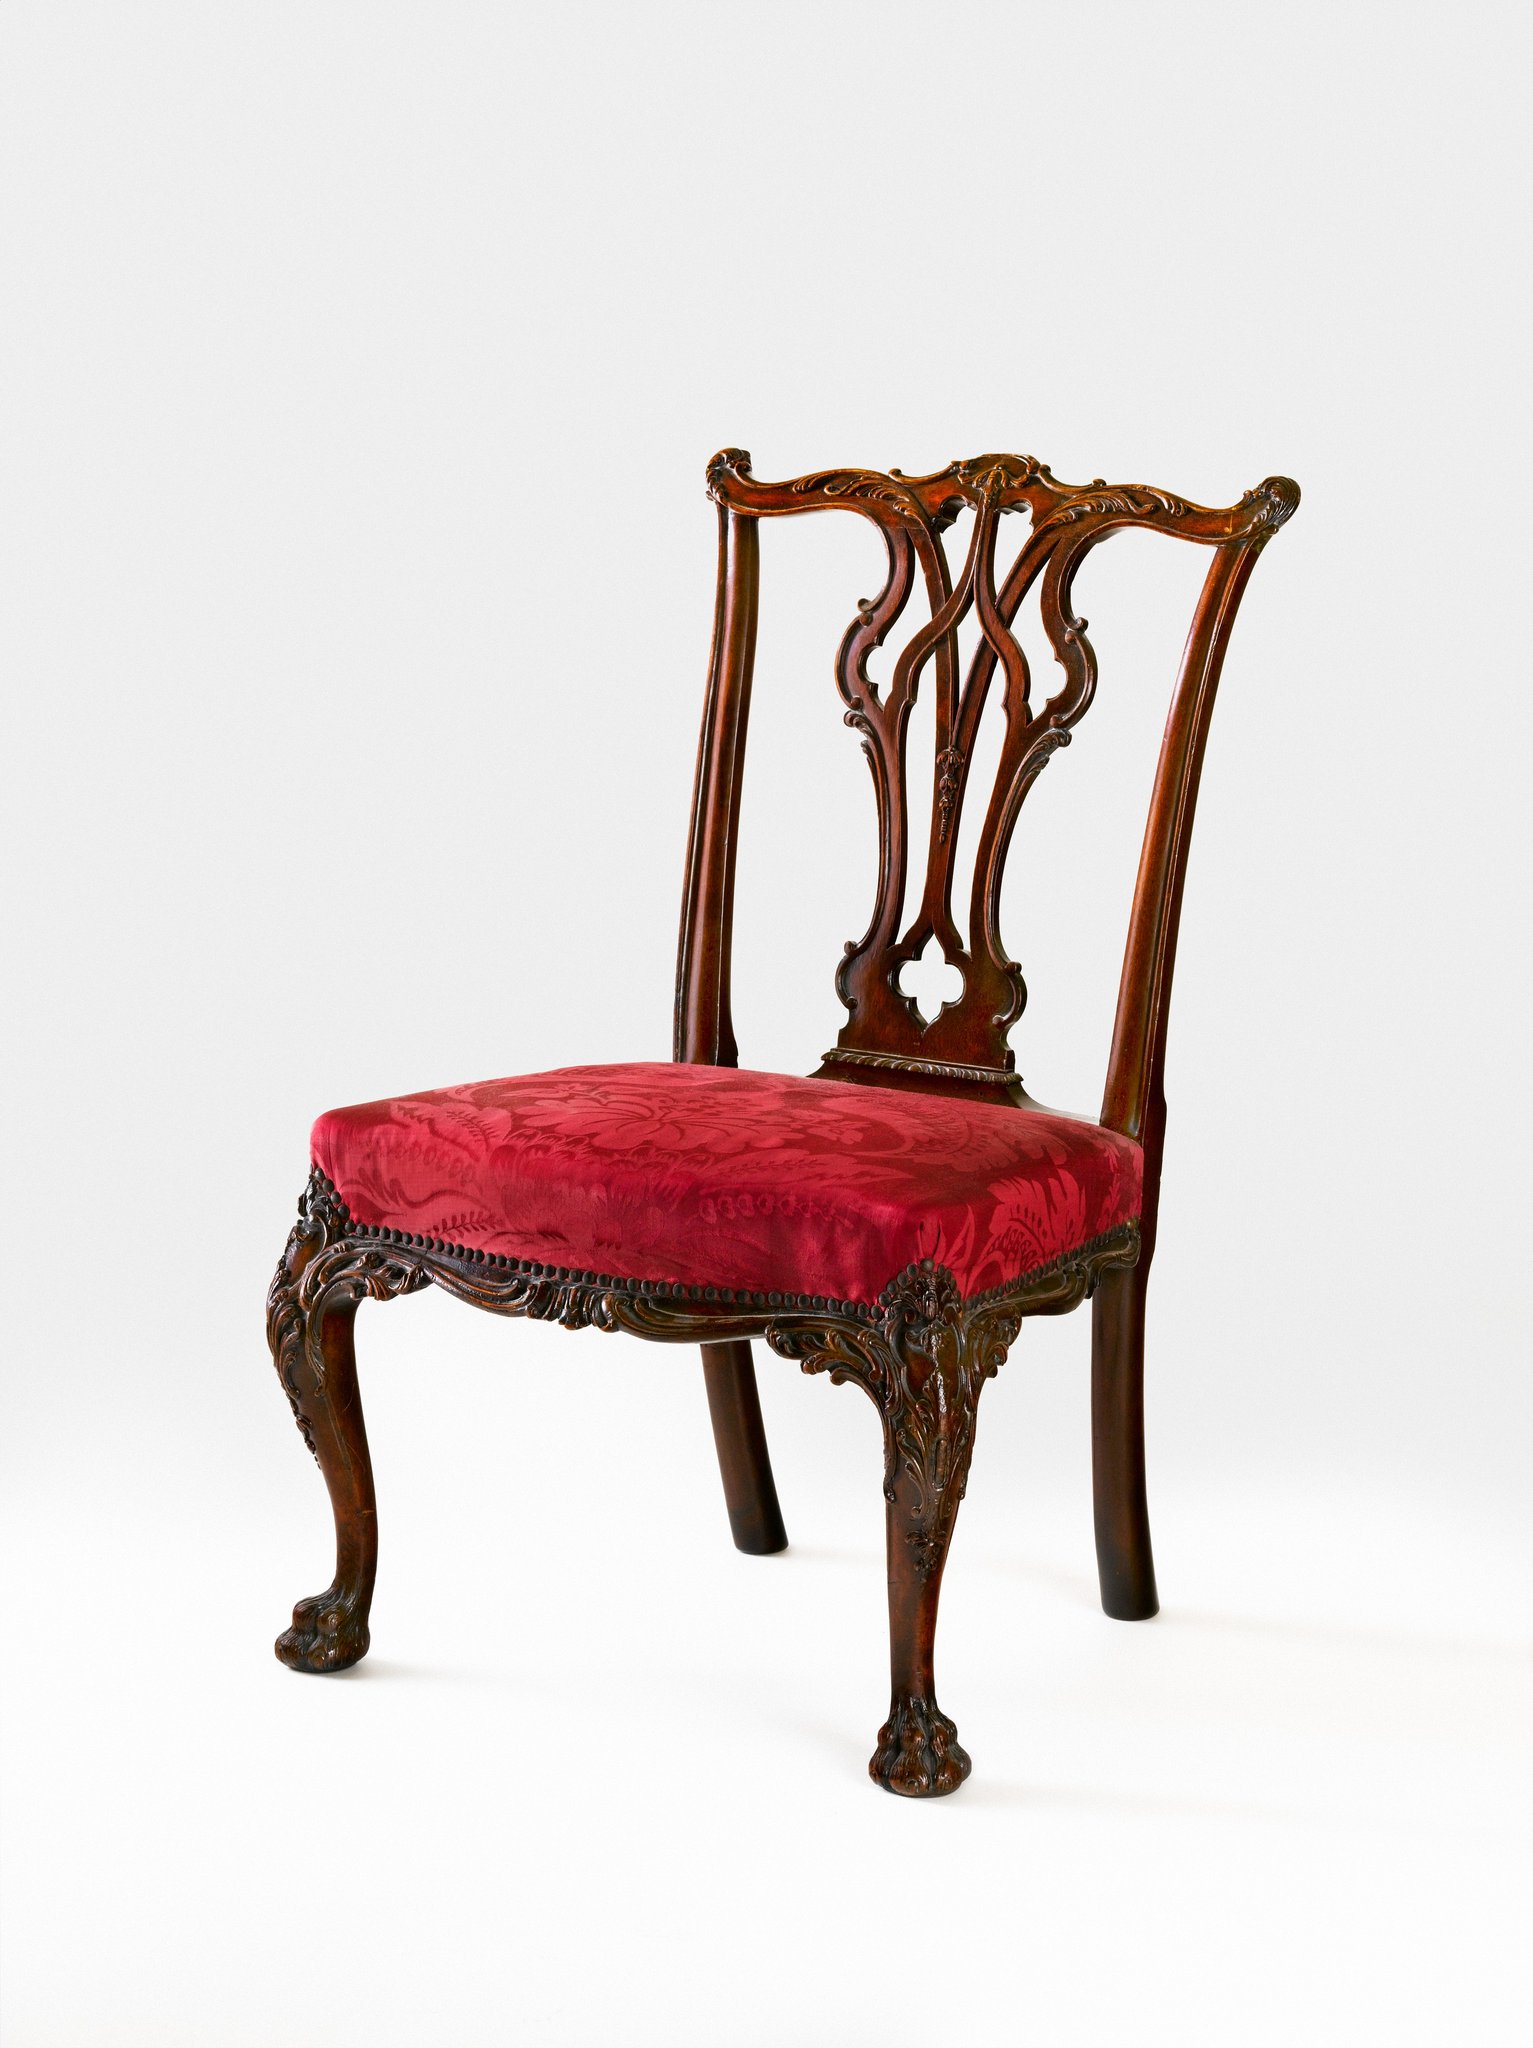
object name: side chair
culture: american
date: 1760-1790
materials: wood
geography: united states